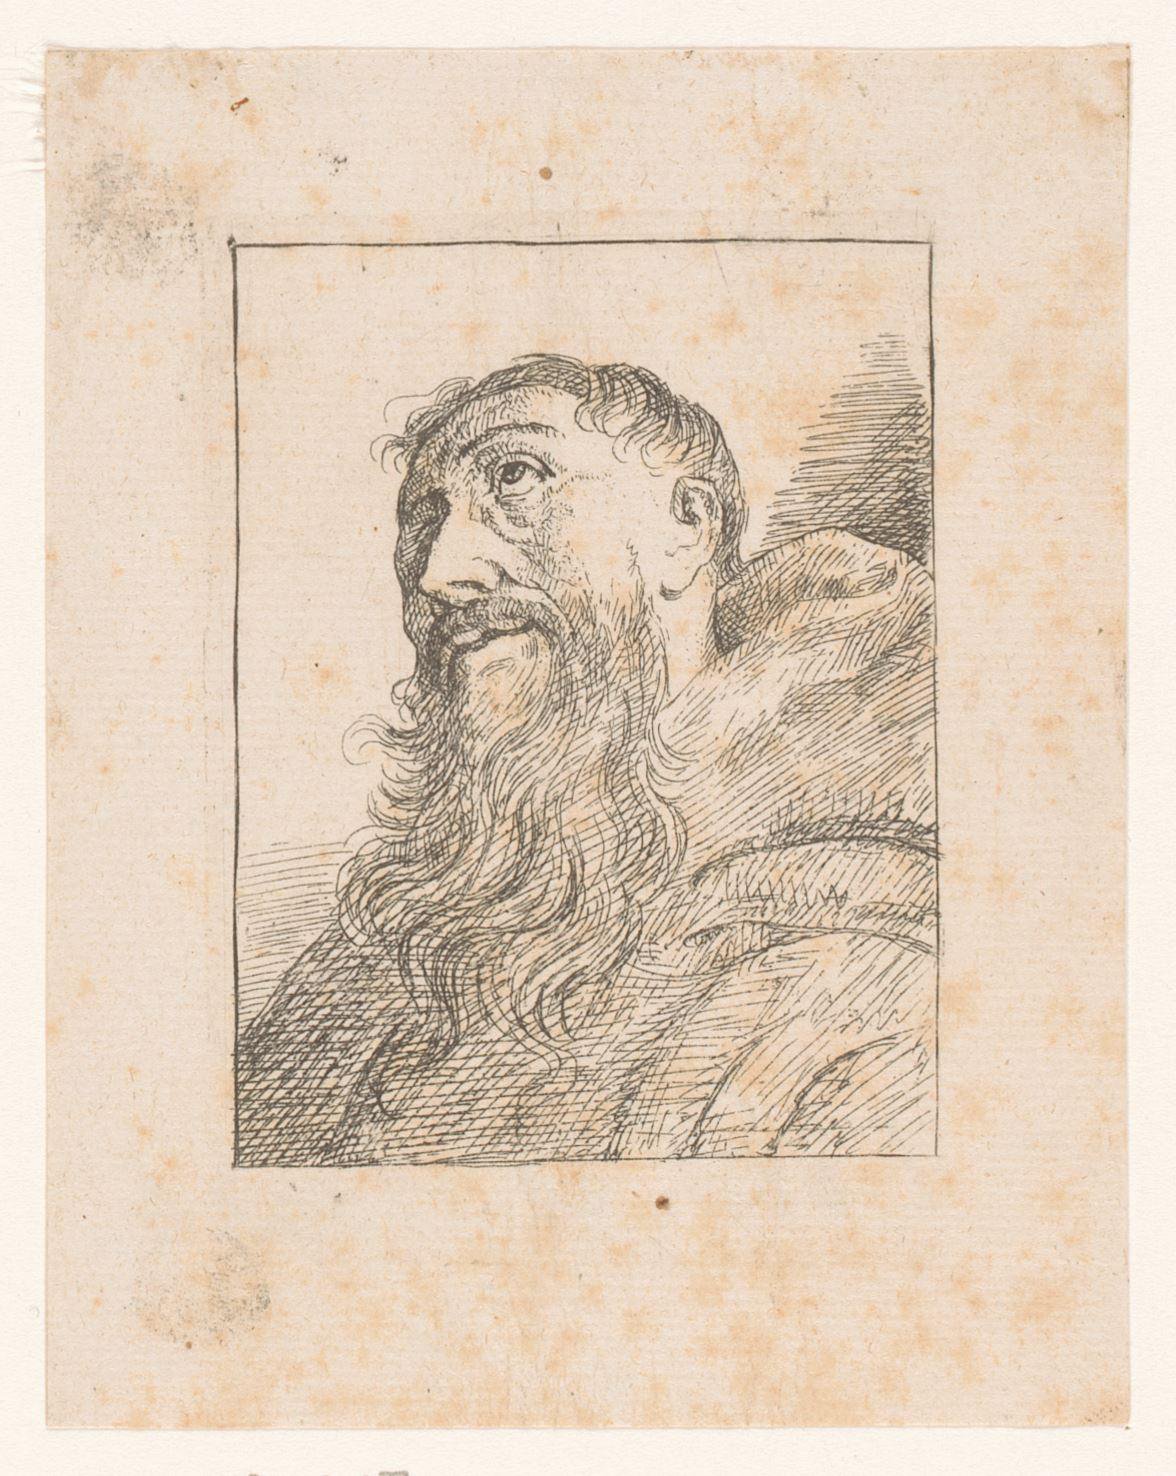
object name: print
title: Omhoogkijkende monnik met lange baard en één oog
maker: van der straalen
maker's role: print maker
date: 1775-1874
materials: paper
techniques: printmaking, etching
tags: monk(s), friar(s)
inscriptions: collector's mark: Lugt 2228